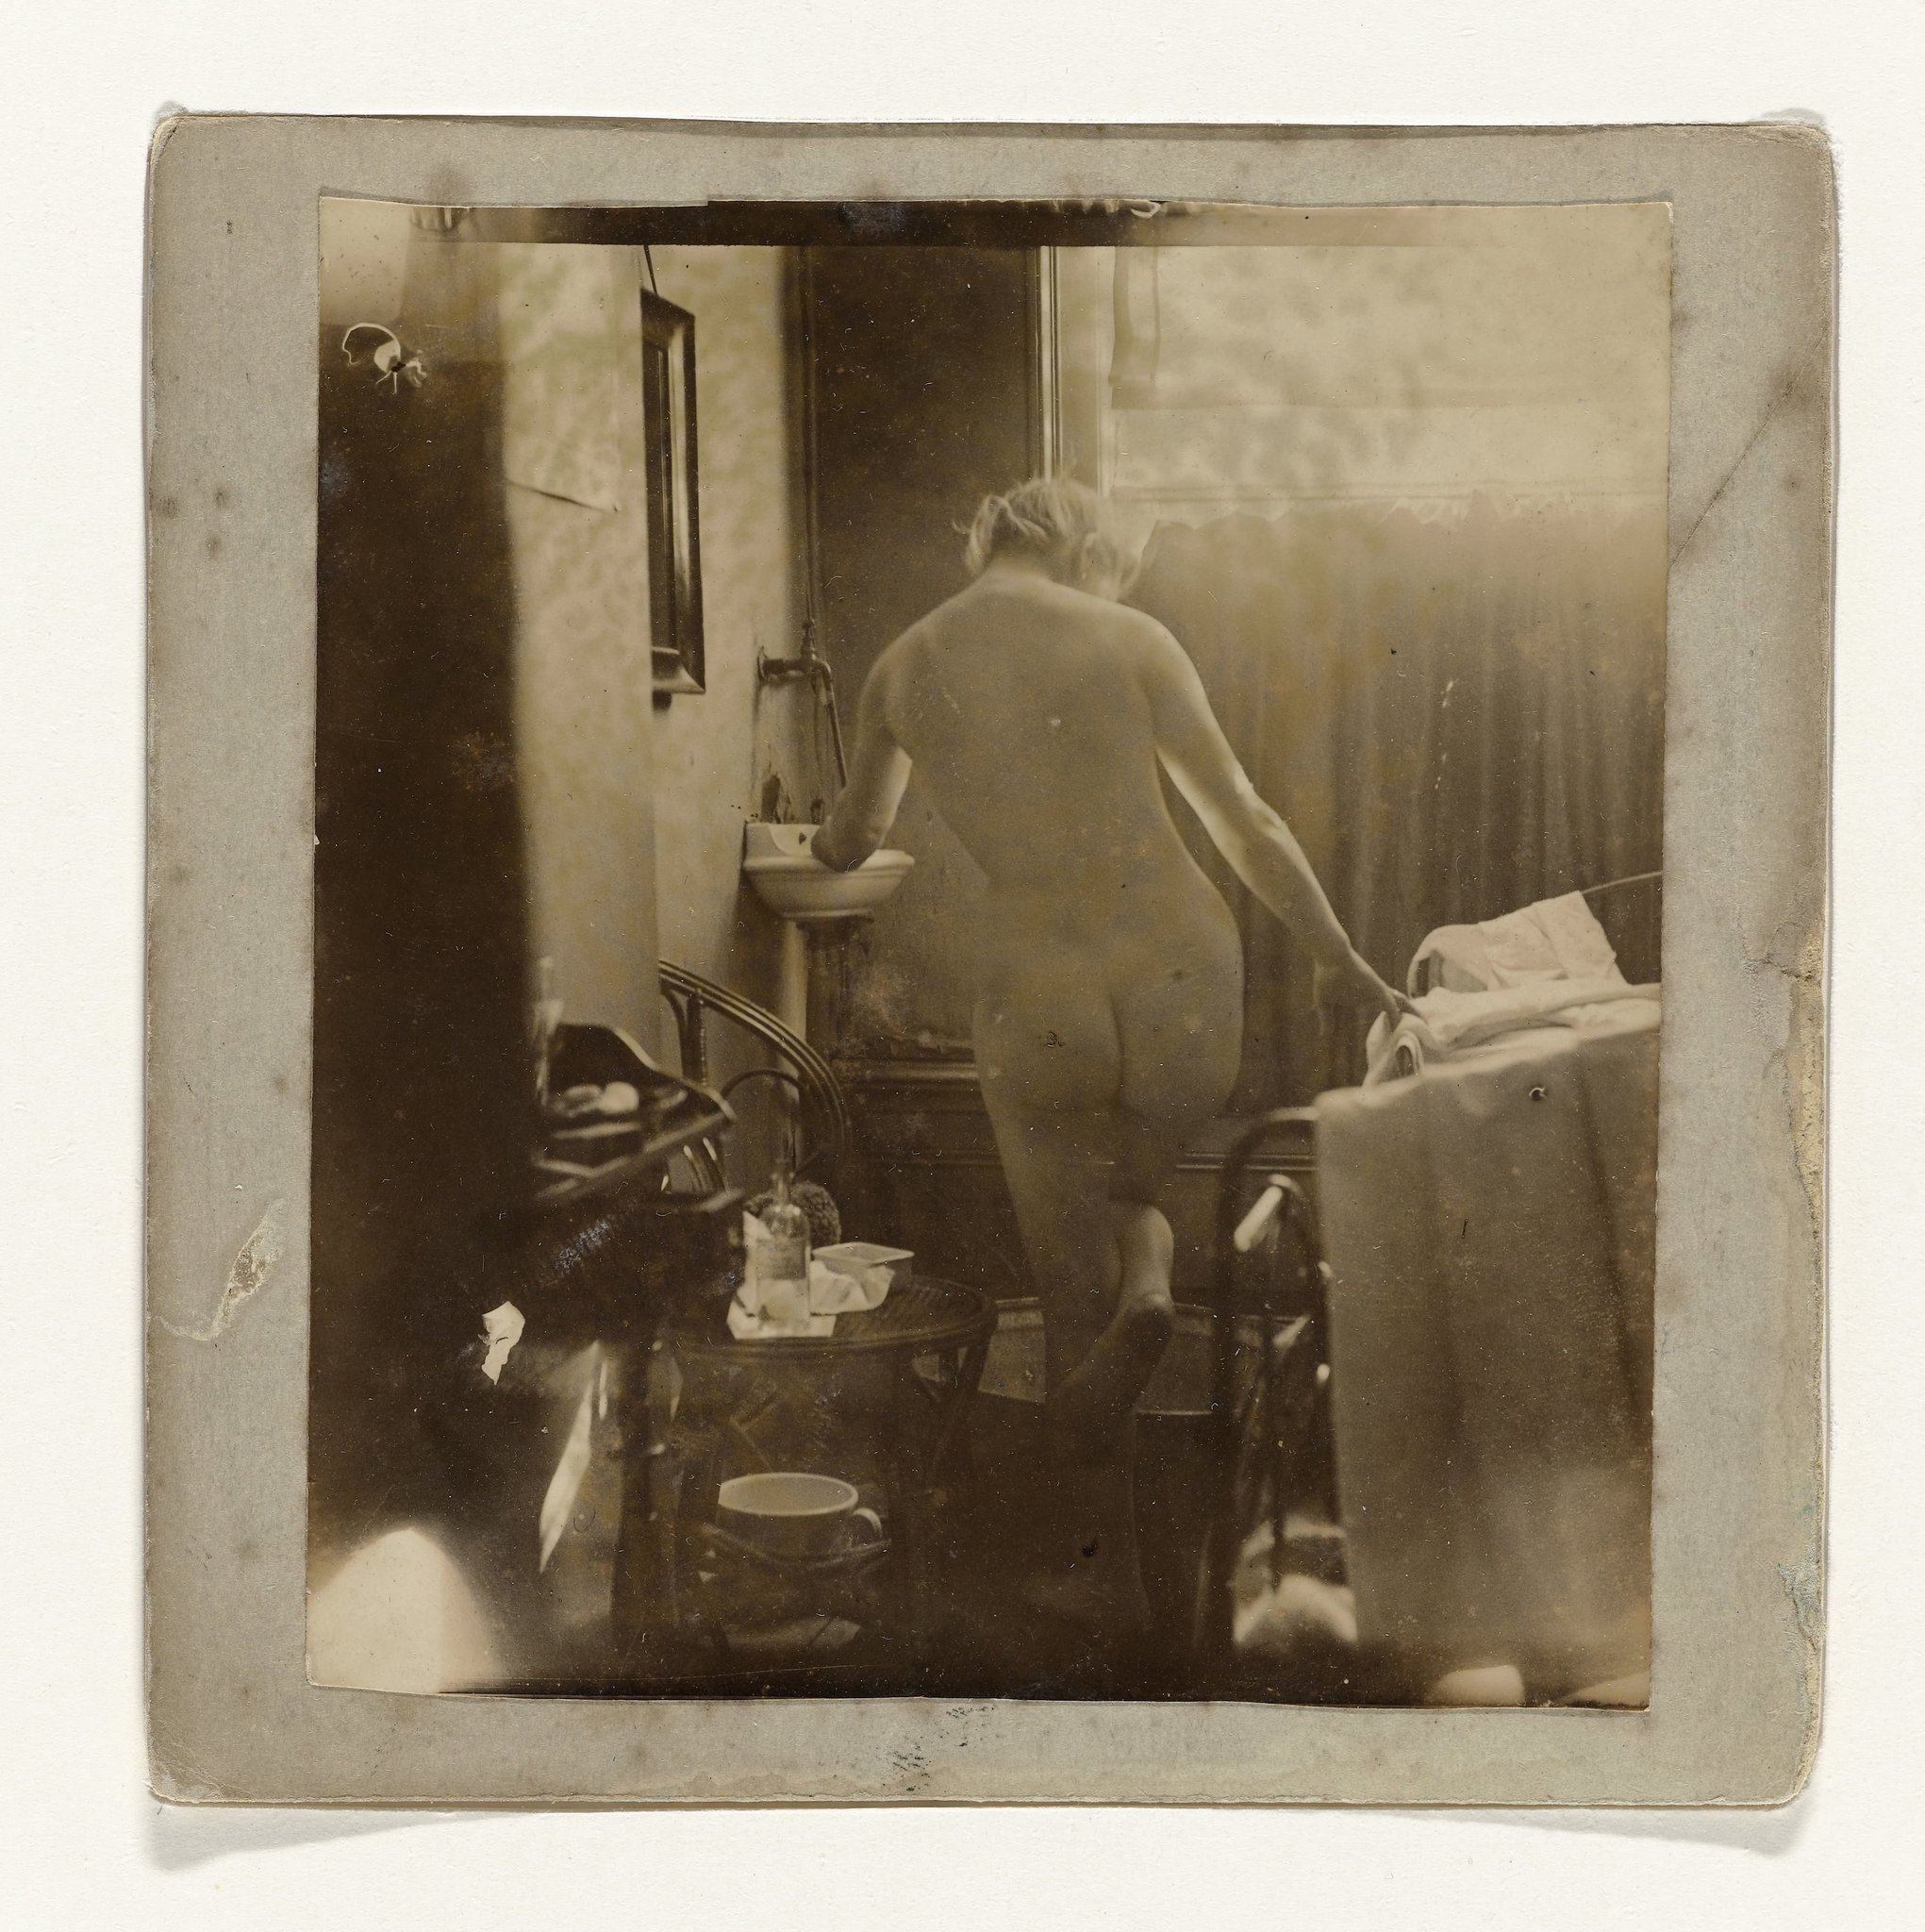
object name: photograph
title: Marie Jordan, Nude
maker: george hendrik breitner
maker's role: draughtsman, painter, print maker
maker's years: 1857-1923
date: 1889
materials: cardboard, photographic support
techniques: gelatin silver print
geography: amsterdam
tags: amsterdam, marie jordan, the (nude) human figure; 'corpo humano' (ripa) - aa - female human figure (+ back view)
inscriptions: inscription: ‘B’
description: The painter Breitner was also a fanatical amateur photographer. His pictures of Amsterdam are widely known, but not the amateur’s intimate personal photographs in a small format, pasted on cardboard. They are from the property of Marie Jordan, Breitner’s girlfriend and later wife. They always remained private.